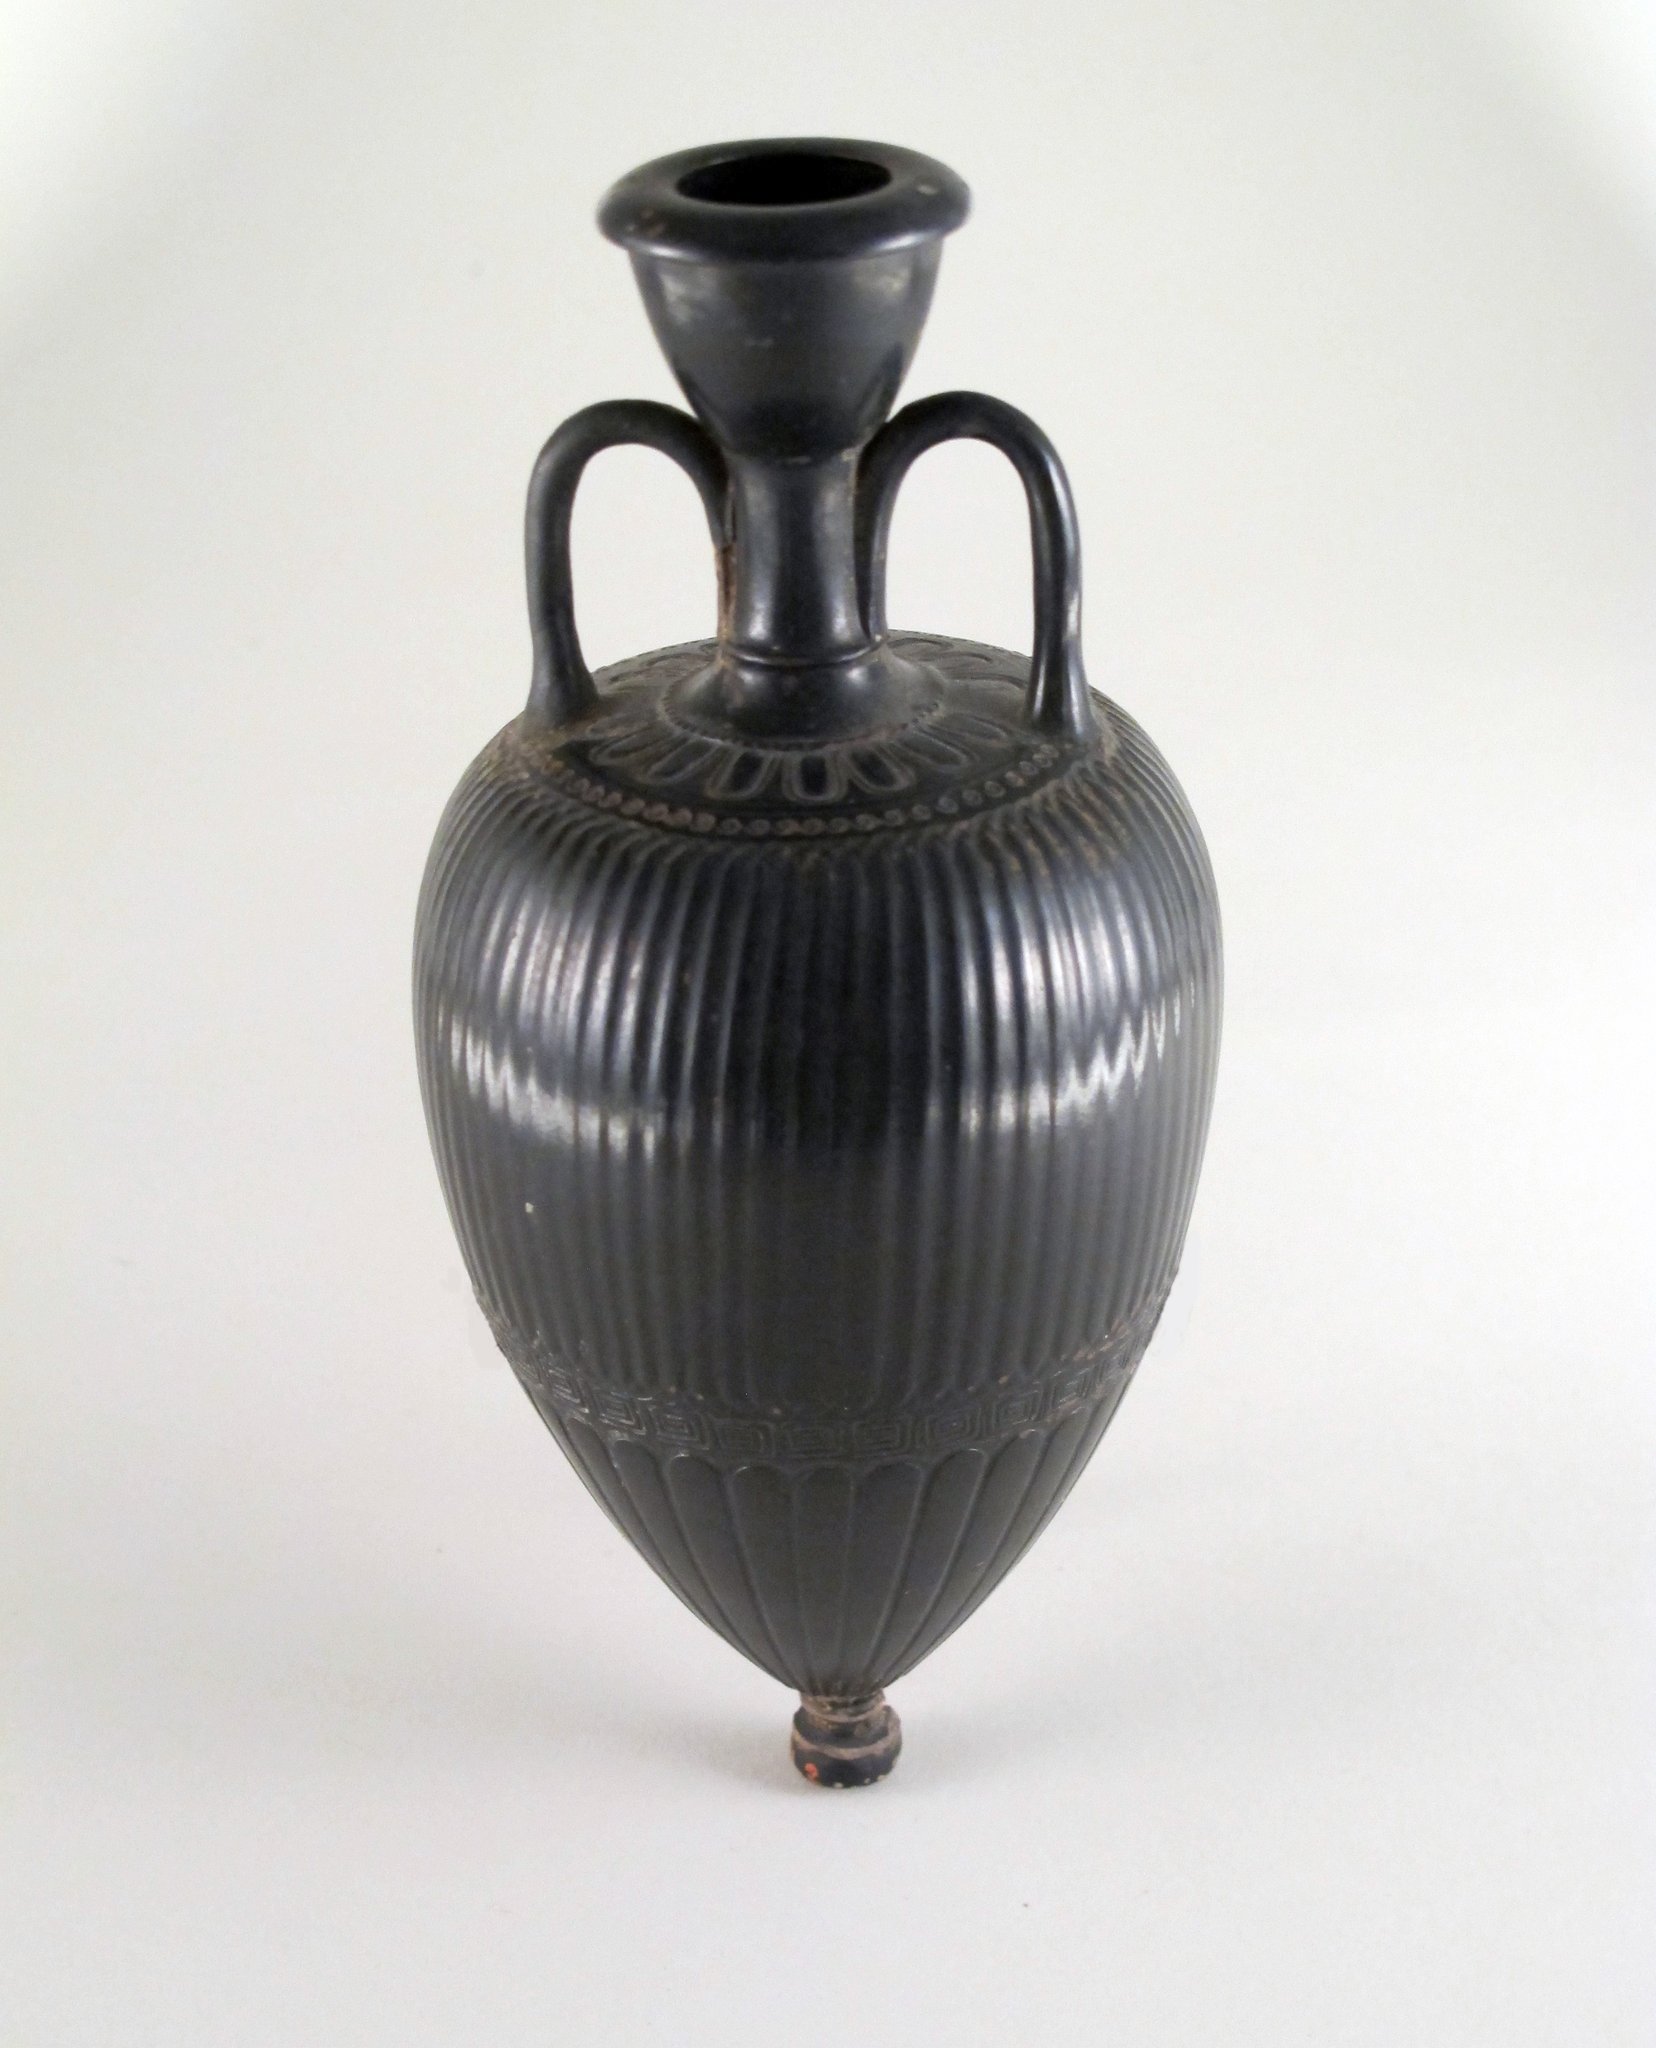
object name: amphoriskos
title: Terracotta amphoriskos (flask)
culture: greek, attic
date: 400-301 BCE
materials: terracotta